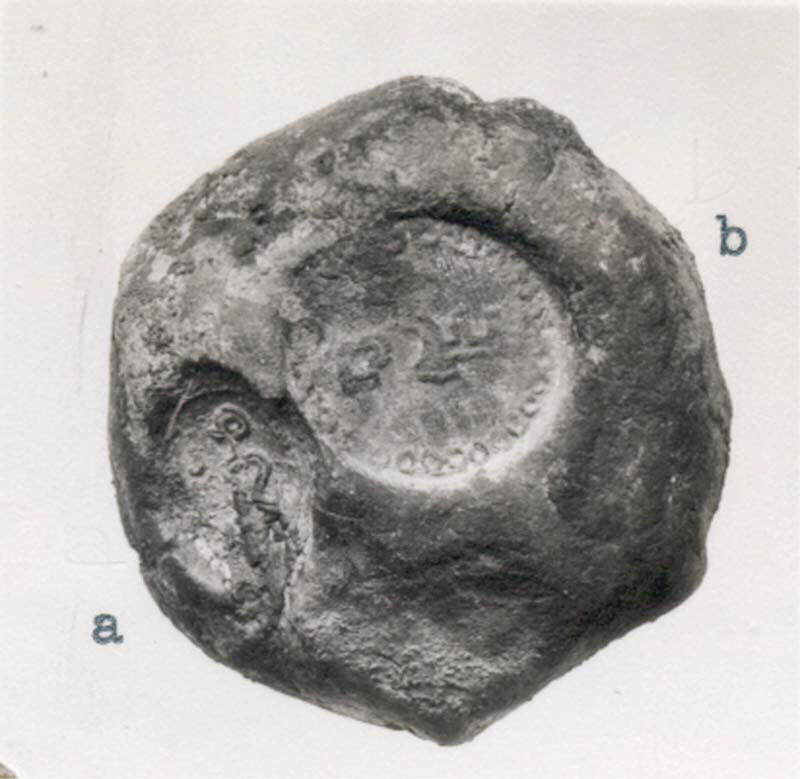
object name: sealing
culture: sasanian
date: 601-700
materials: clay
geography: iran